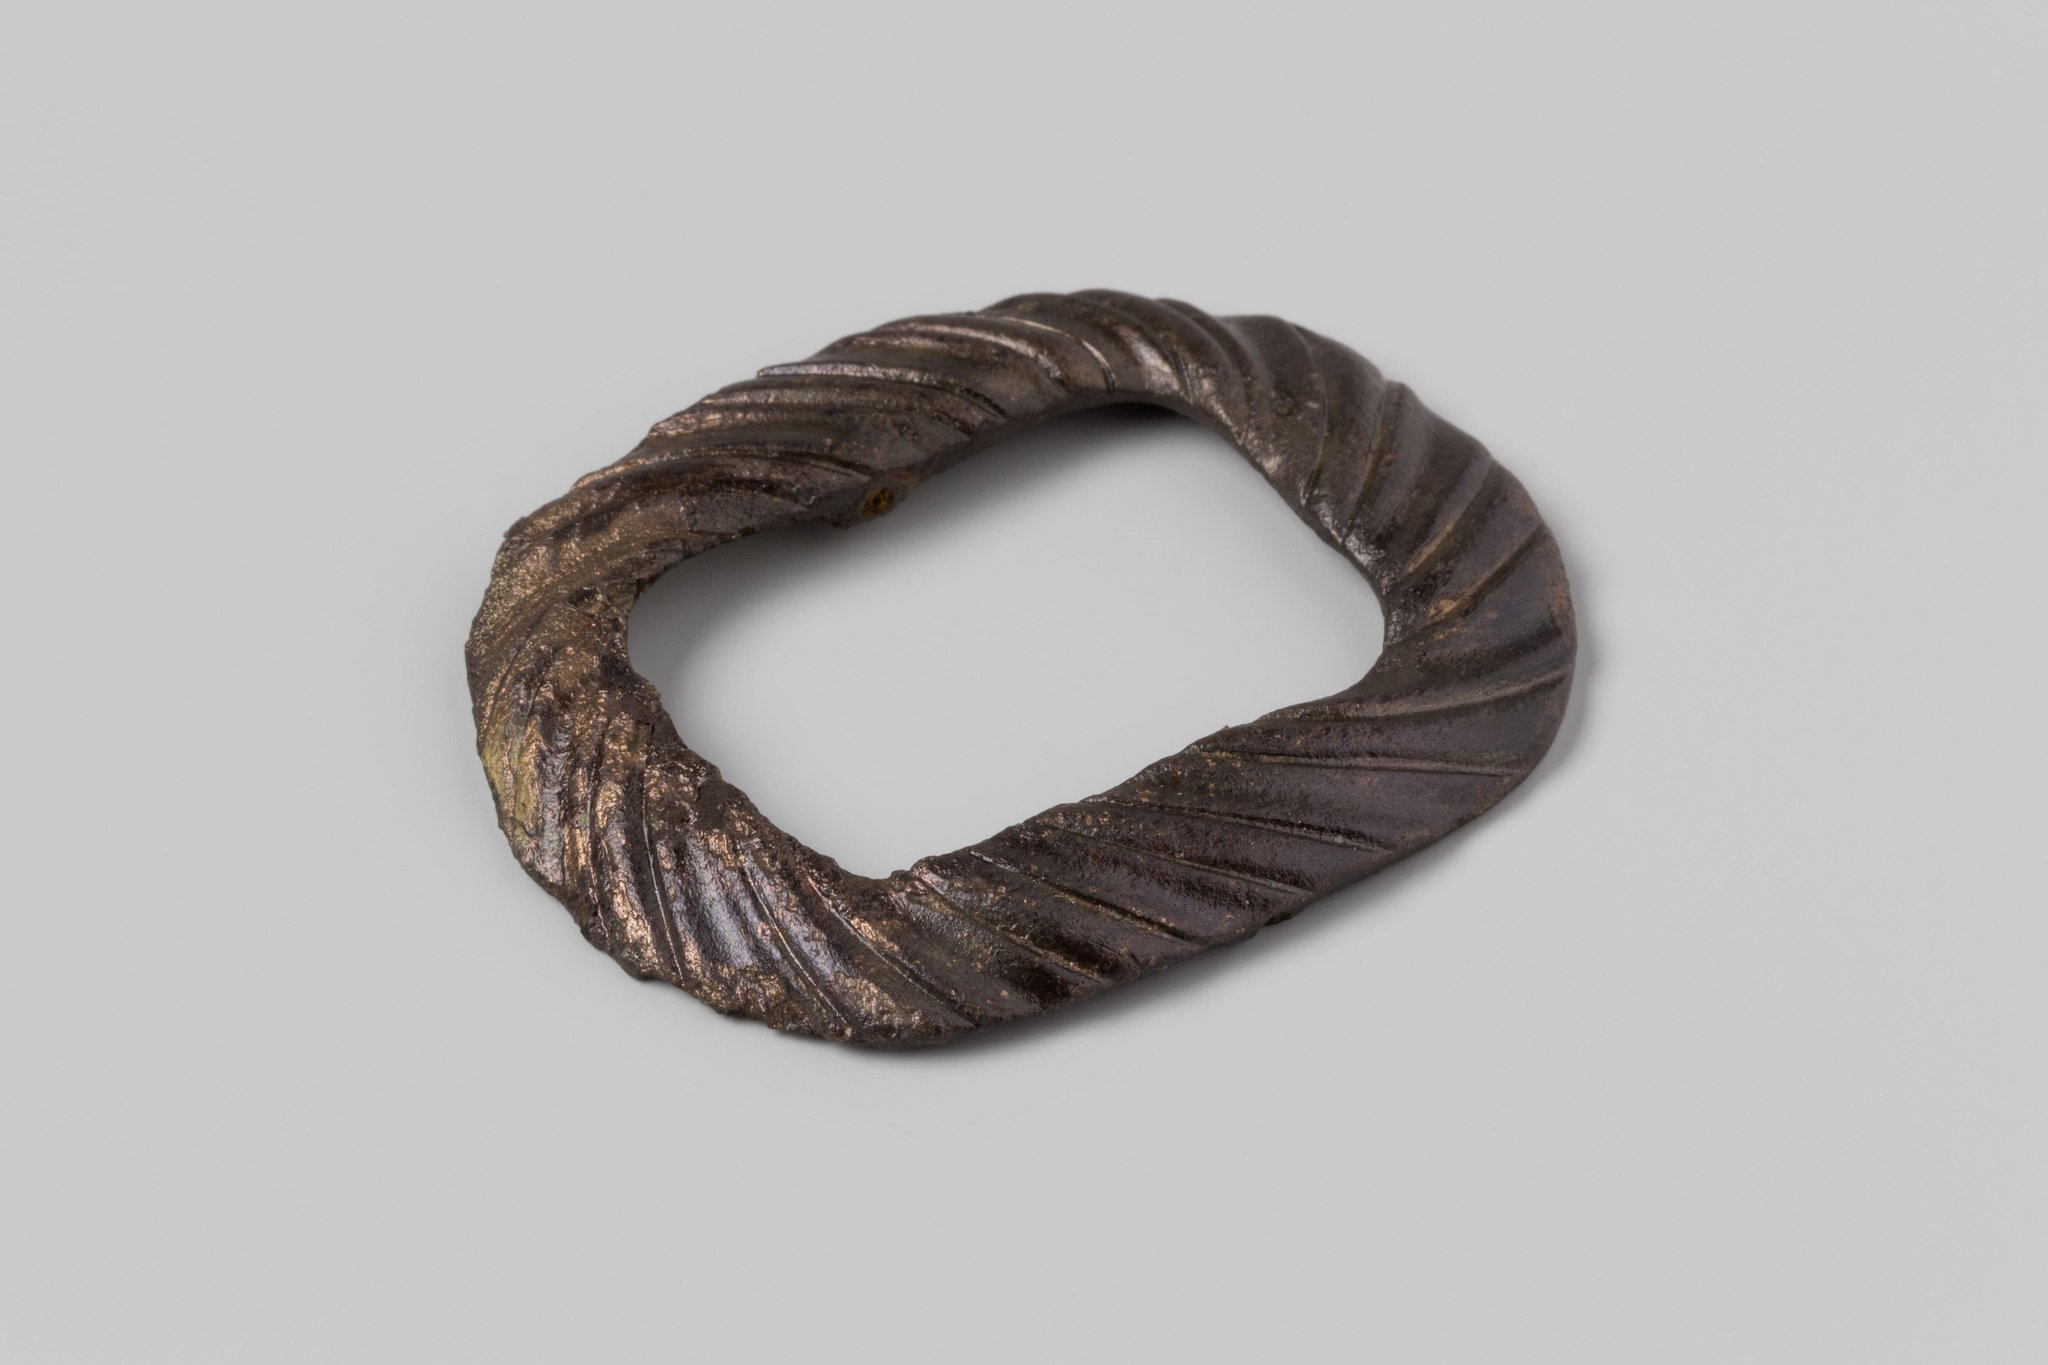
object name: shoe buckle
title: Schoengesp uit het wrak van de Oost-Indiëvaarder Hollandia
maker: Anonymous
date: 1700-1743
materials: copper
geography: netherlands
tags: verenigde oostindische compagnie, hollandia (schip), annet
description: Schoengesp. Buckle, chape buckle, shoe buckle; (1) ring (6x4.7, 0.4t), diagonally ribbed